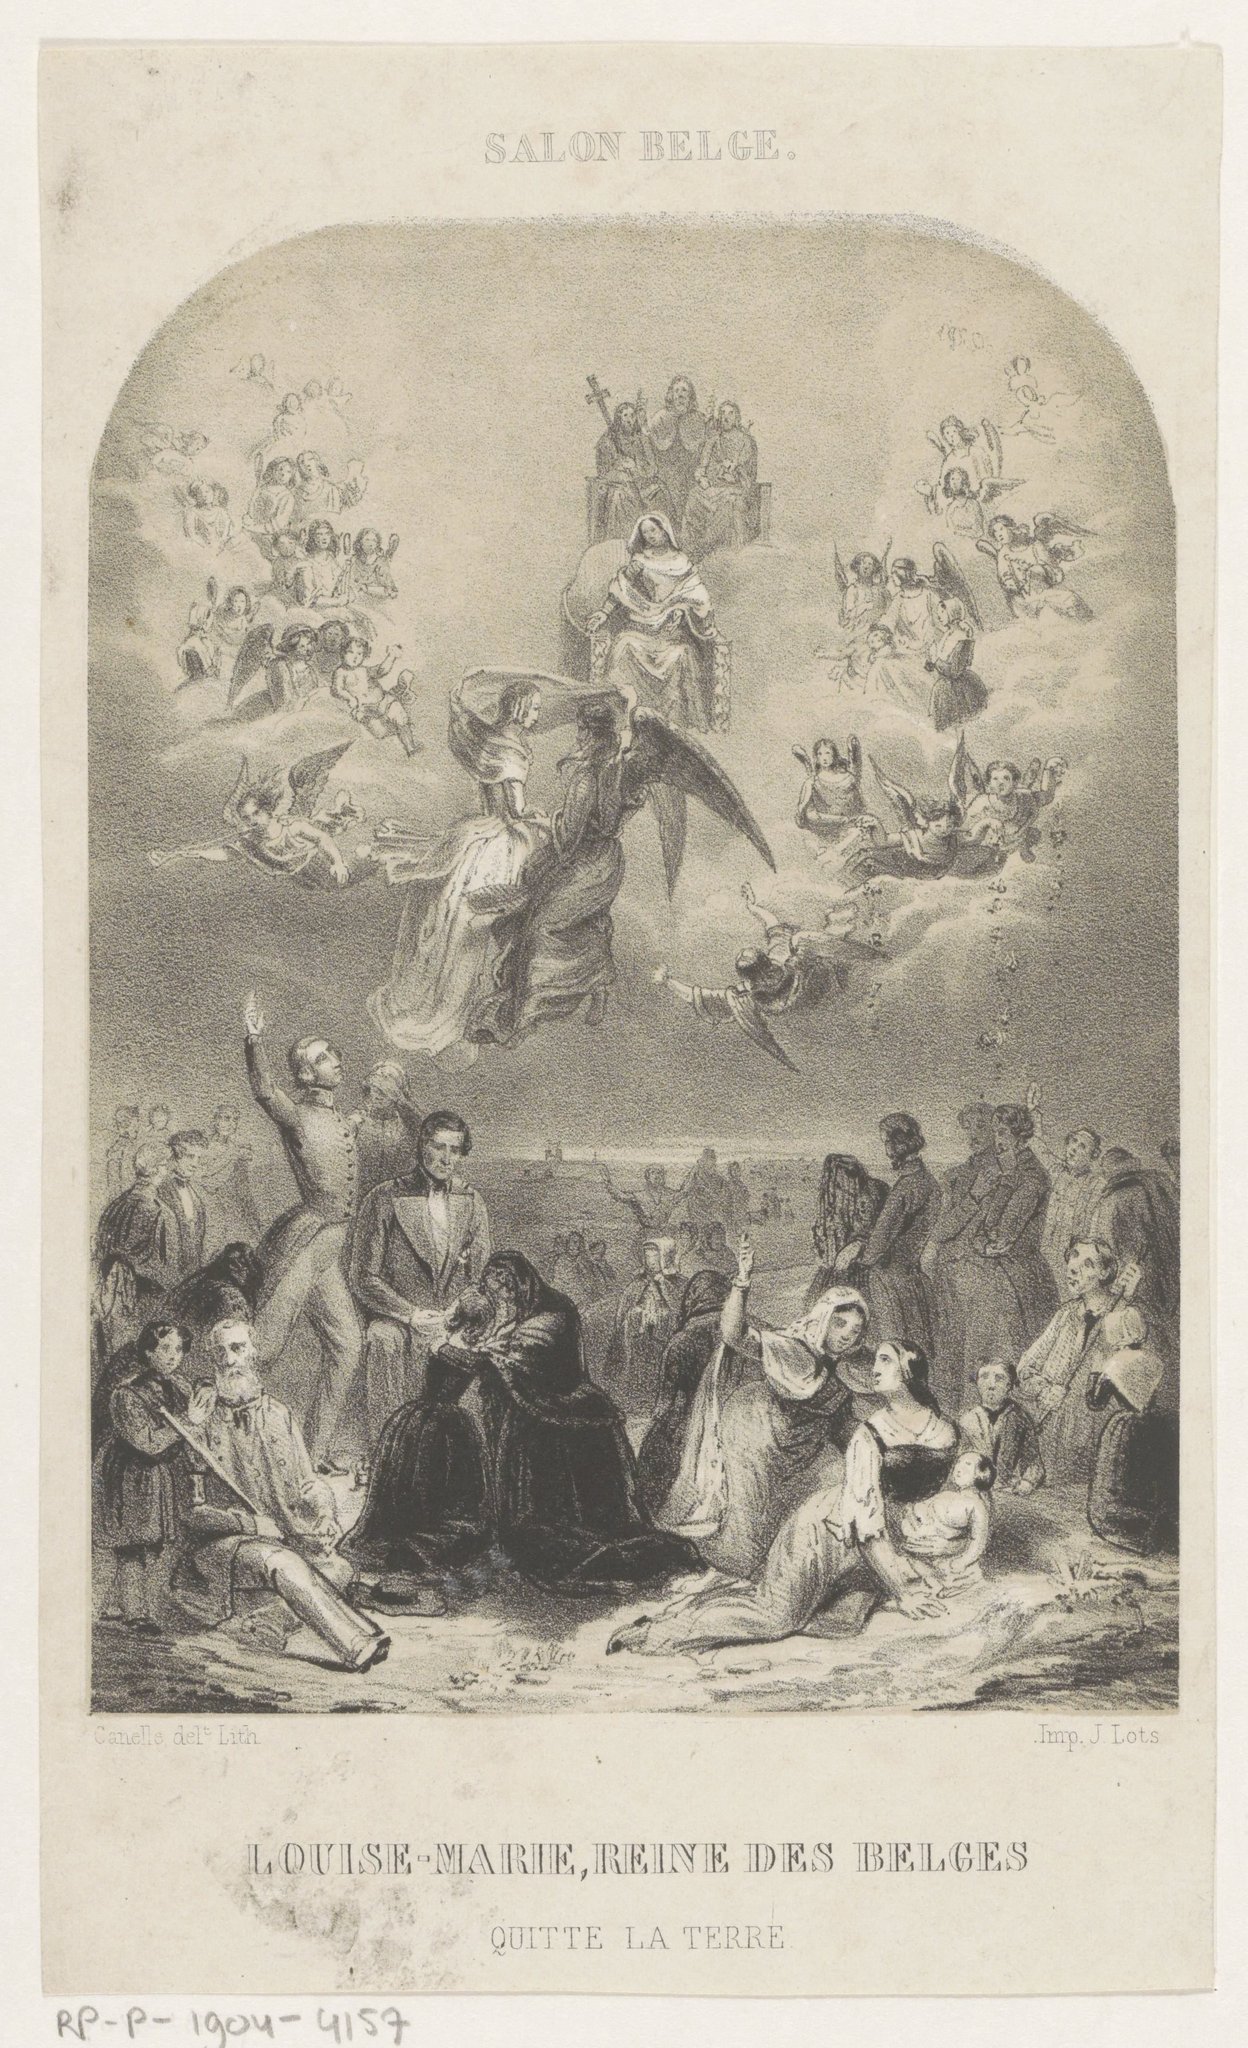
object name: print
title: Hemelvaart van koningin Louise Marie van Orléans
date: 1829-1869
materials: paper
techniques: tone lithography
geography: brussels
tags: louise marie van orléans (koningin van belgië), (ascent into) heaven, the holy trinity, 'trinitas coelestis'; father, son and holy ghost ~ christian religion (+ mary), angels, belgium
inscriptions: collector's mark: Lugt 2228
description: Op de grond zijn Belgen van alle rangen en standen bij elkaar gekomen. Zij treuren en troosten elkaar. In het midden stijgt de koningin op onder begeleiding van een engel. Maria, gezeten op een troon, verwelkomt haar. Links van de koningin een engel met een bazuin, rechts van haar strooit een engel bloemen uit. In de wolken meer engelen en putti. Helemaal bovenin troont de Heilige Drie-eenheid.